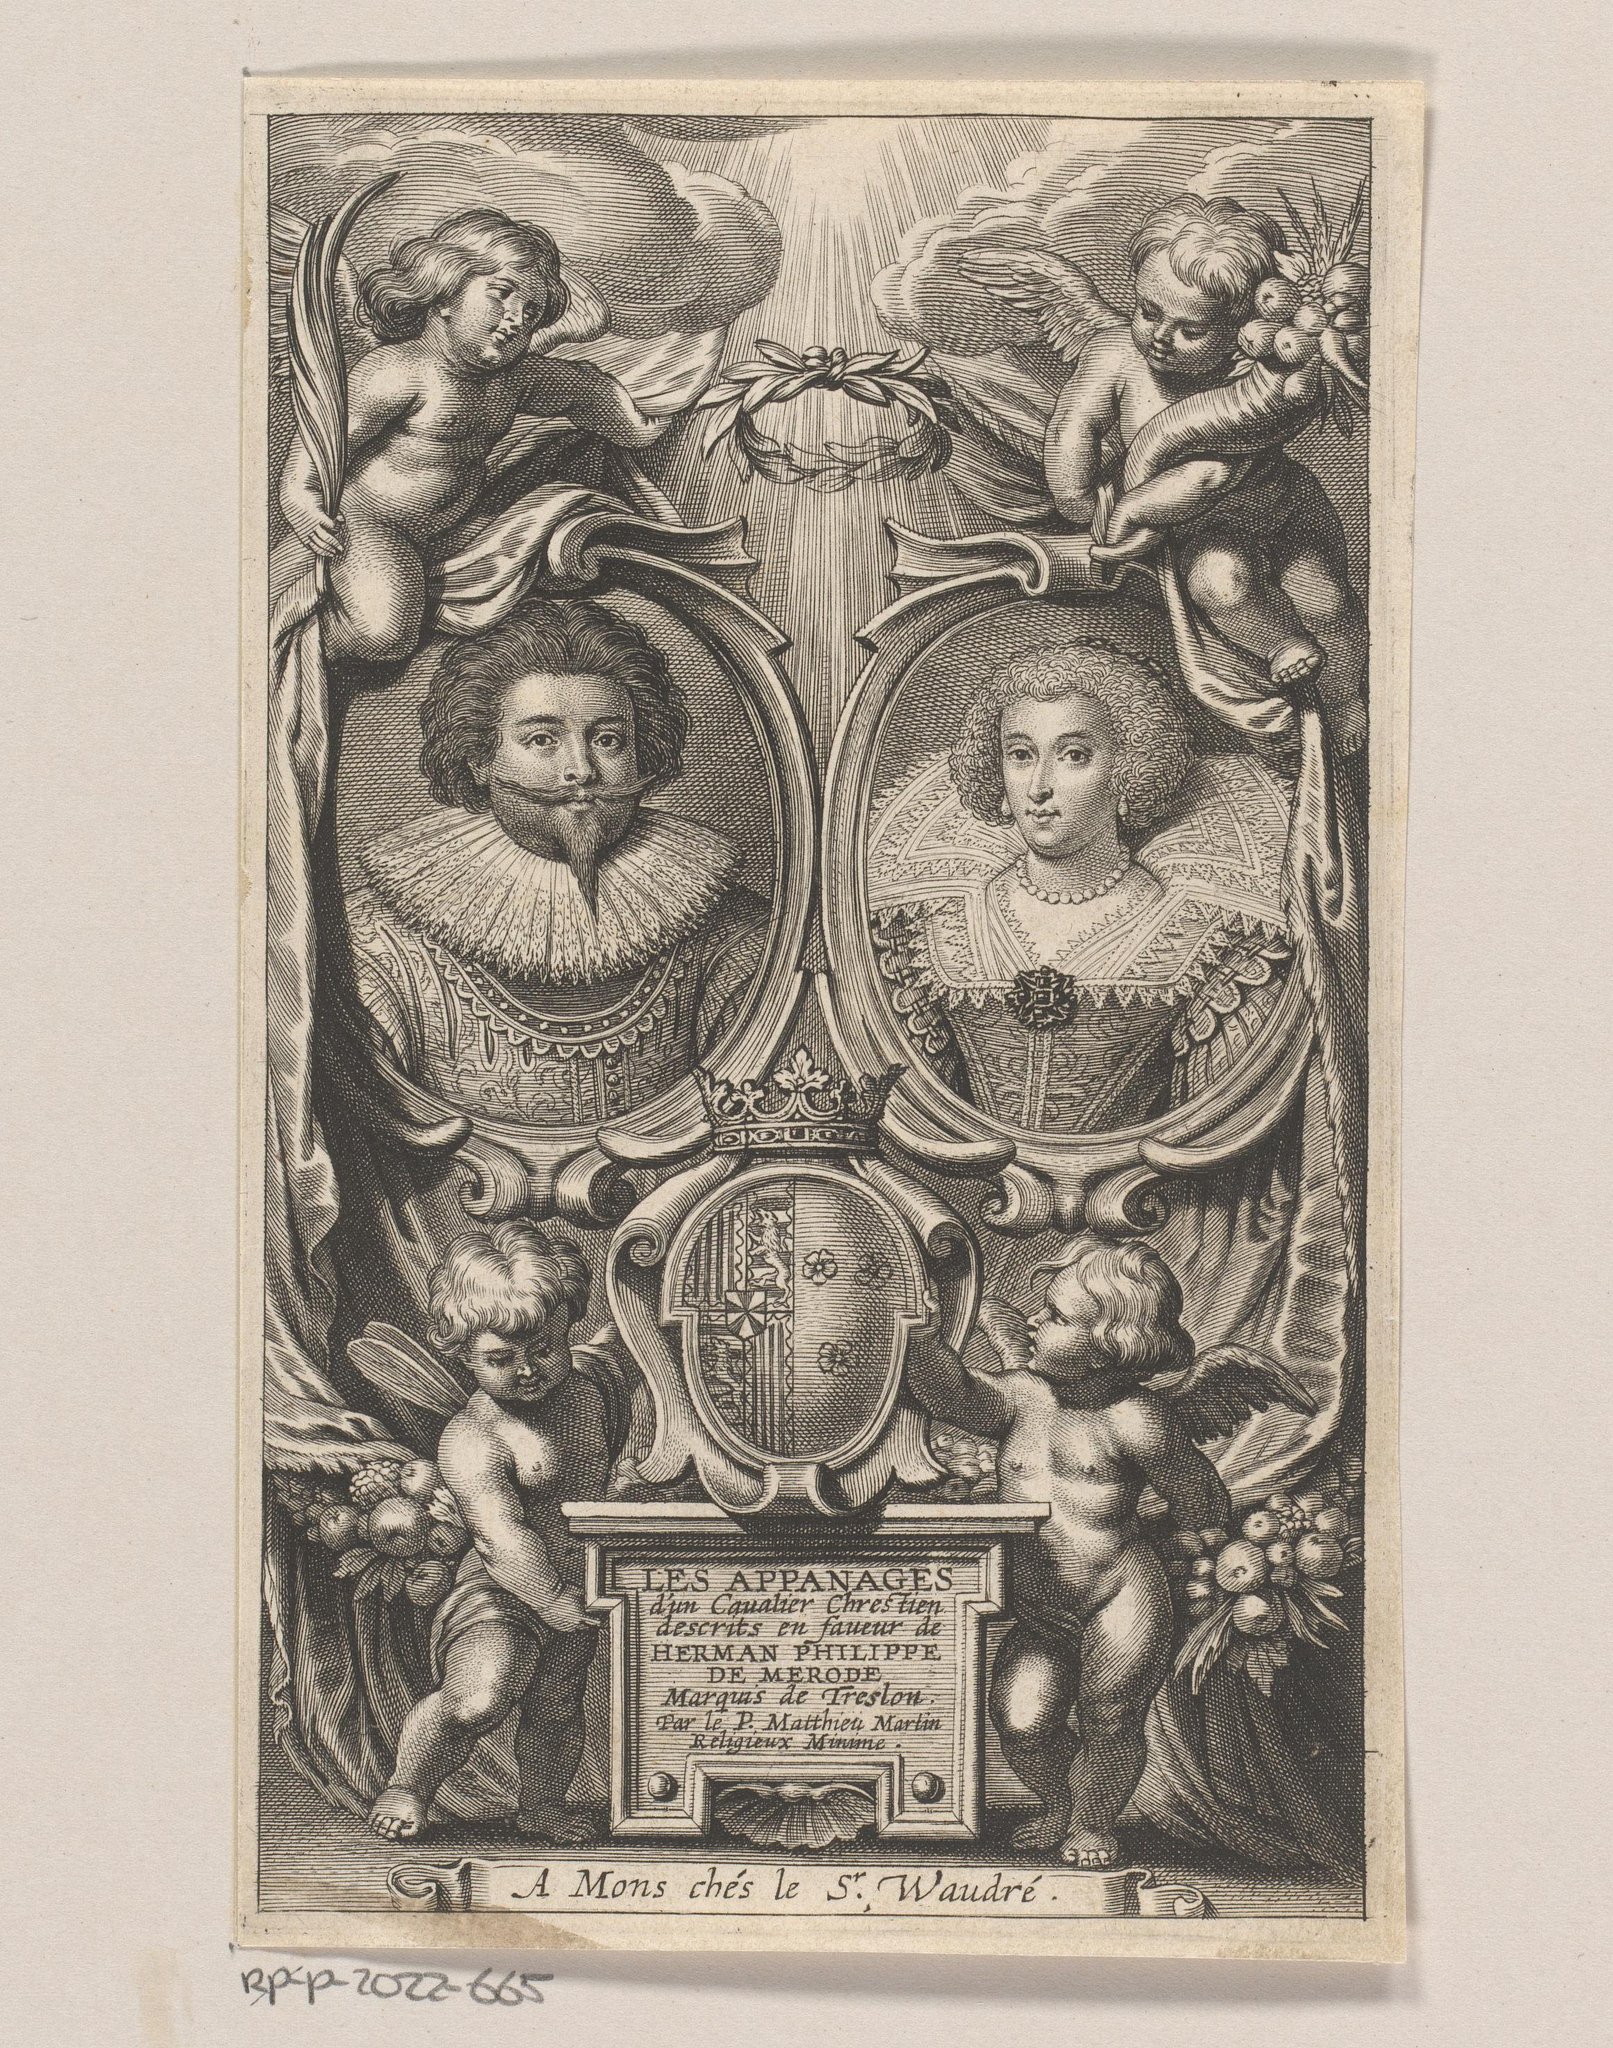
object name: print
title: Portret van Herman Philips van Mérode en Alertine de Ligne Arenberg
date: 1628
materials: paper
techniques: engraving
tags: historical persons - bb - woman, historical persons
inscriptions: collector's mark: Lugt 2228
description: Prent waarschijnlijk uit: Martin, Matthieu. Les Appanages d'un Cavalier Chrestien. S.l.: S. Waudré, 1628.